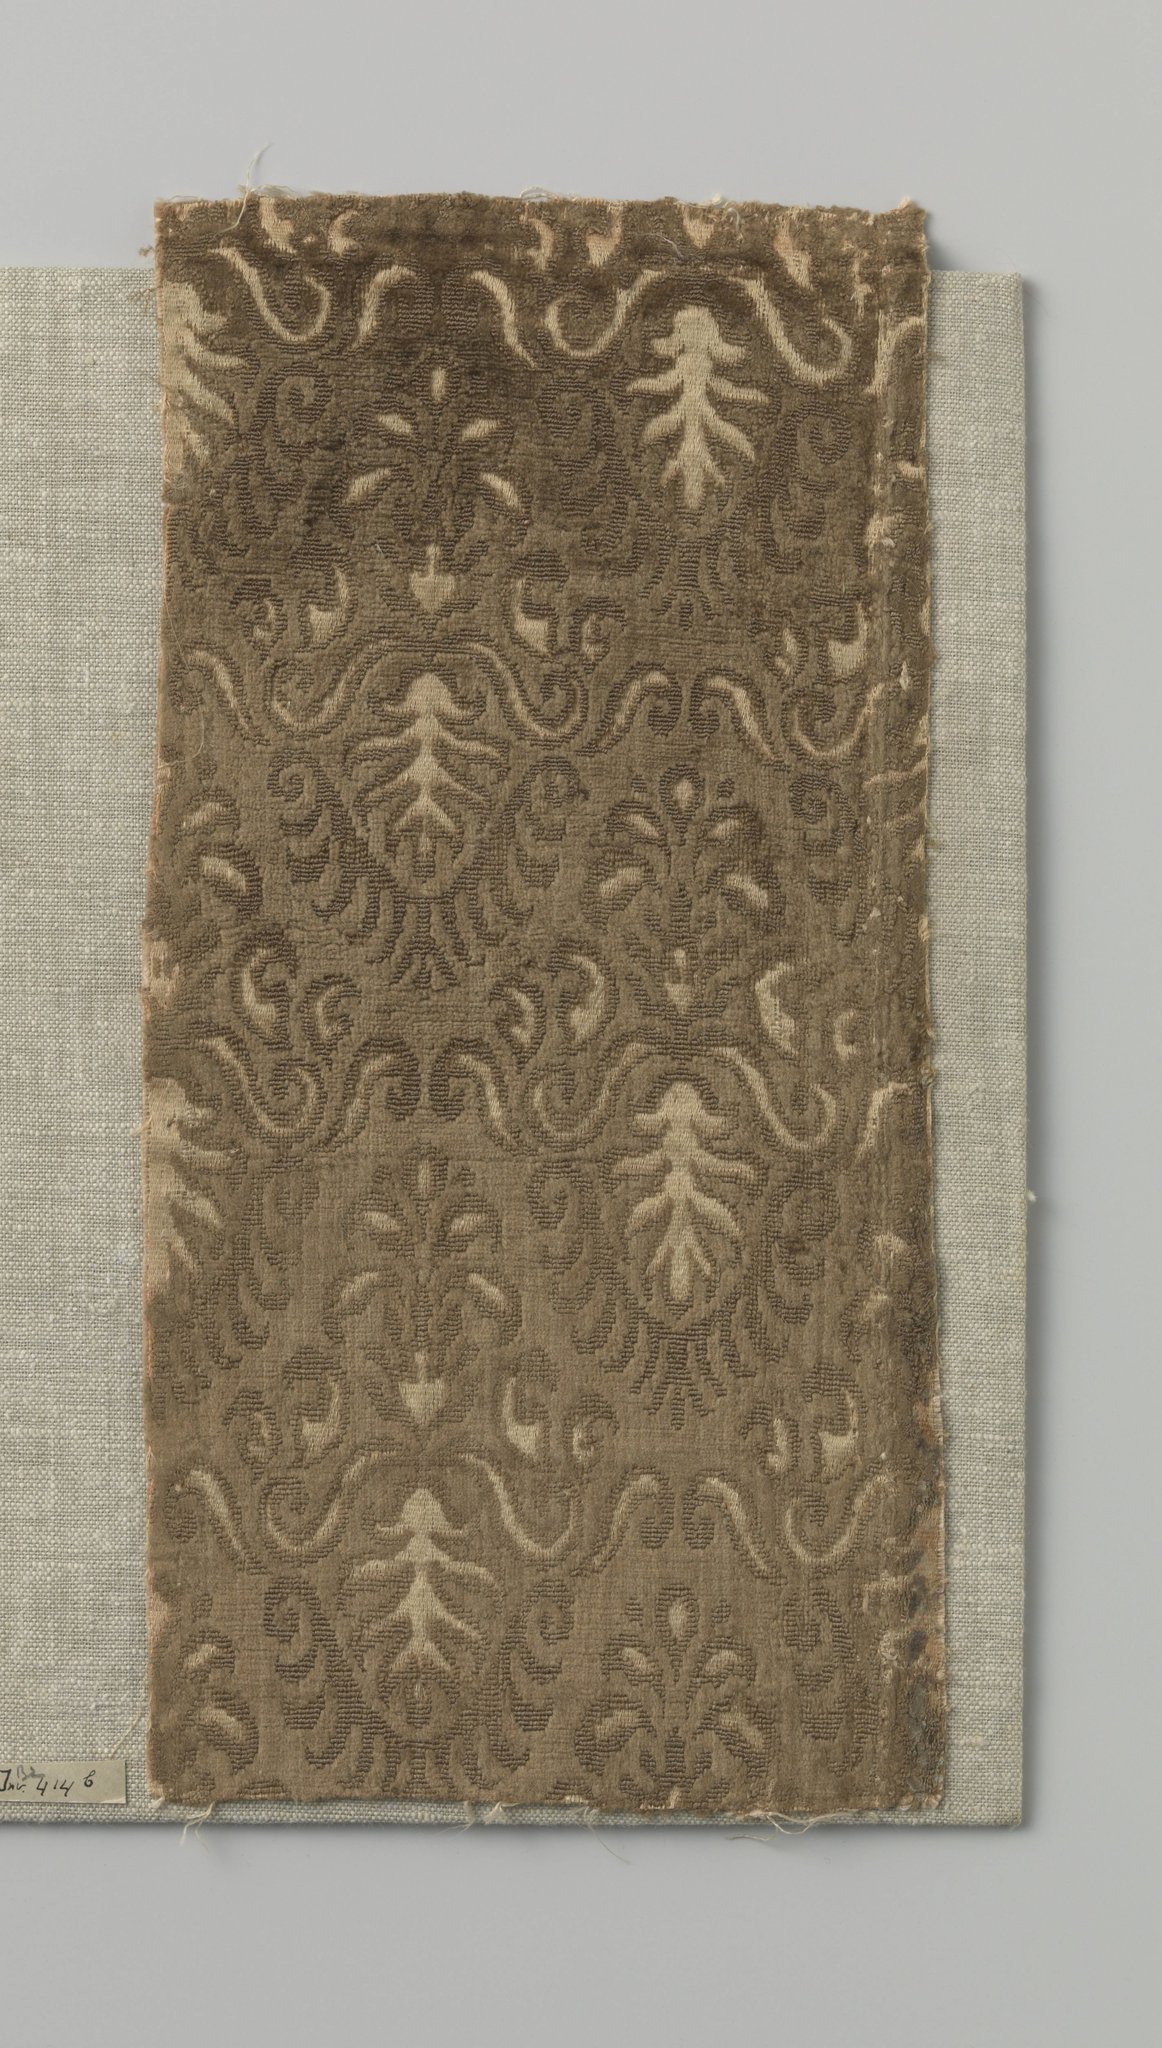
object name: zijdefluweel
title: Fragment bruin ciseléfluweel met patroon van palmetten met in beige uitgespaarde nerven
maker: Anonymous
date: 1500-1599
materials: silk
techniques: velvet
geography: genoa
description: Fragment bruin zijden ciseléfluweel met uitsparingen met patroon van palmetten met in beige uitgespaarde nerven.